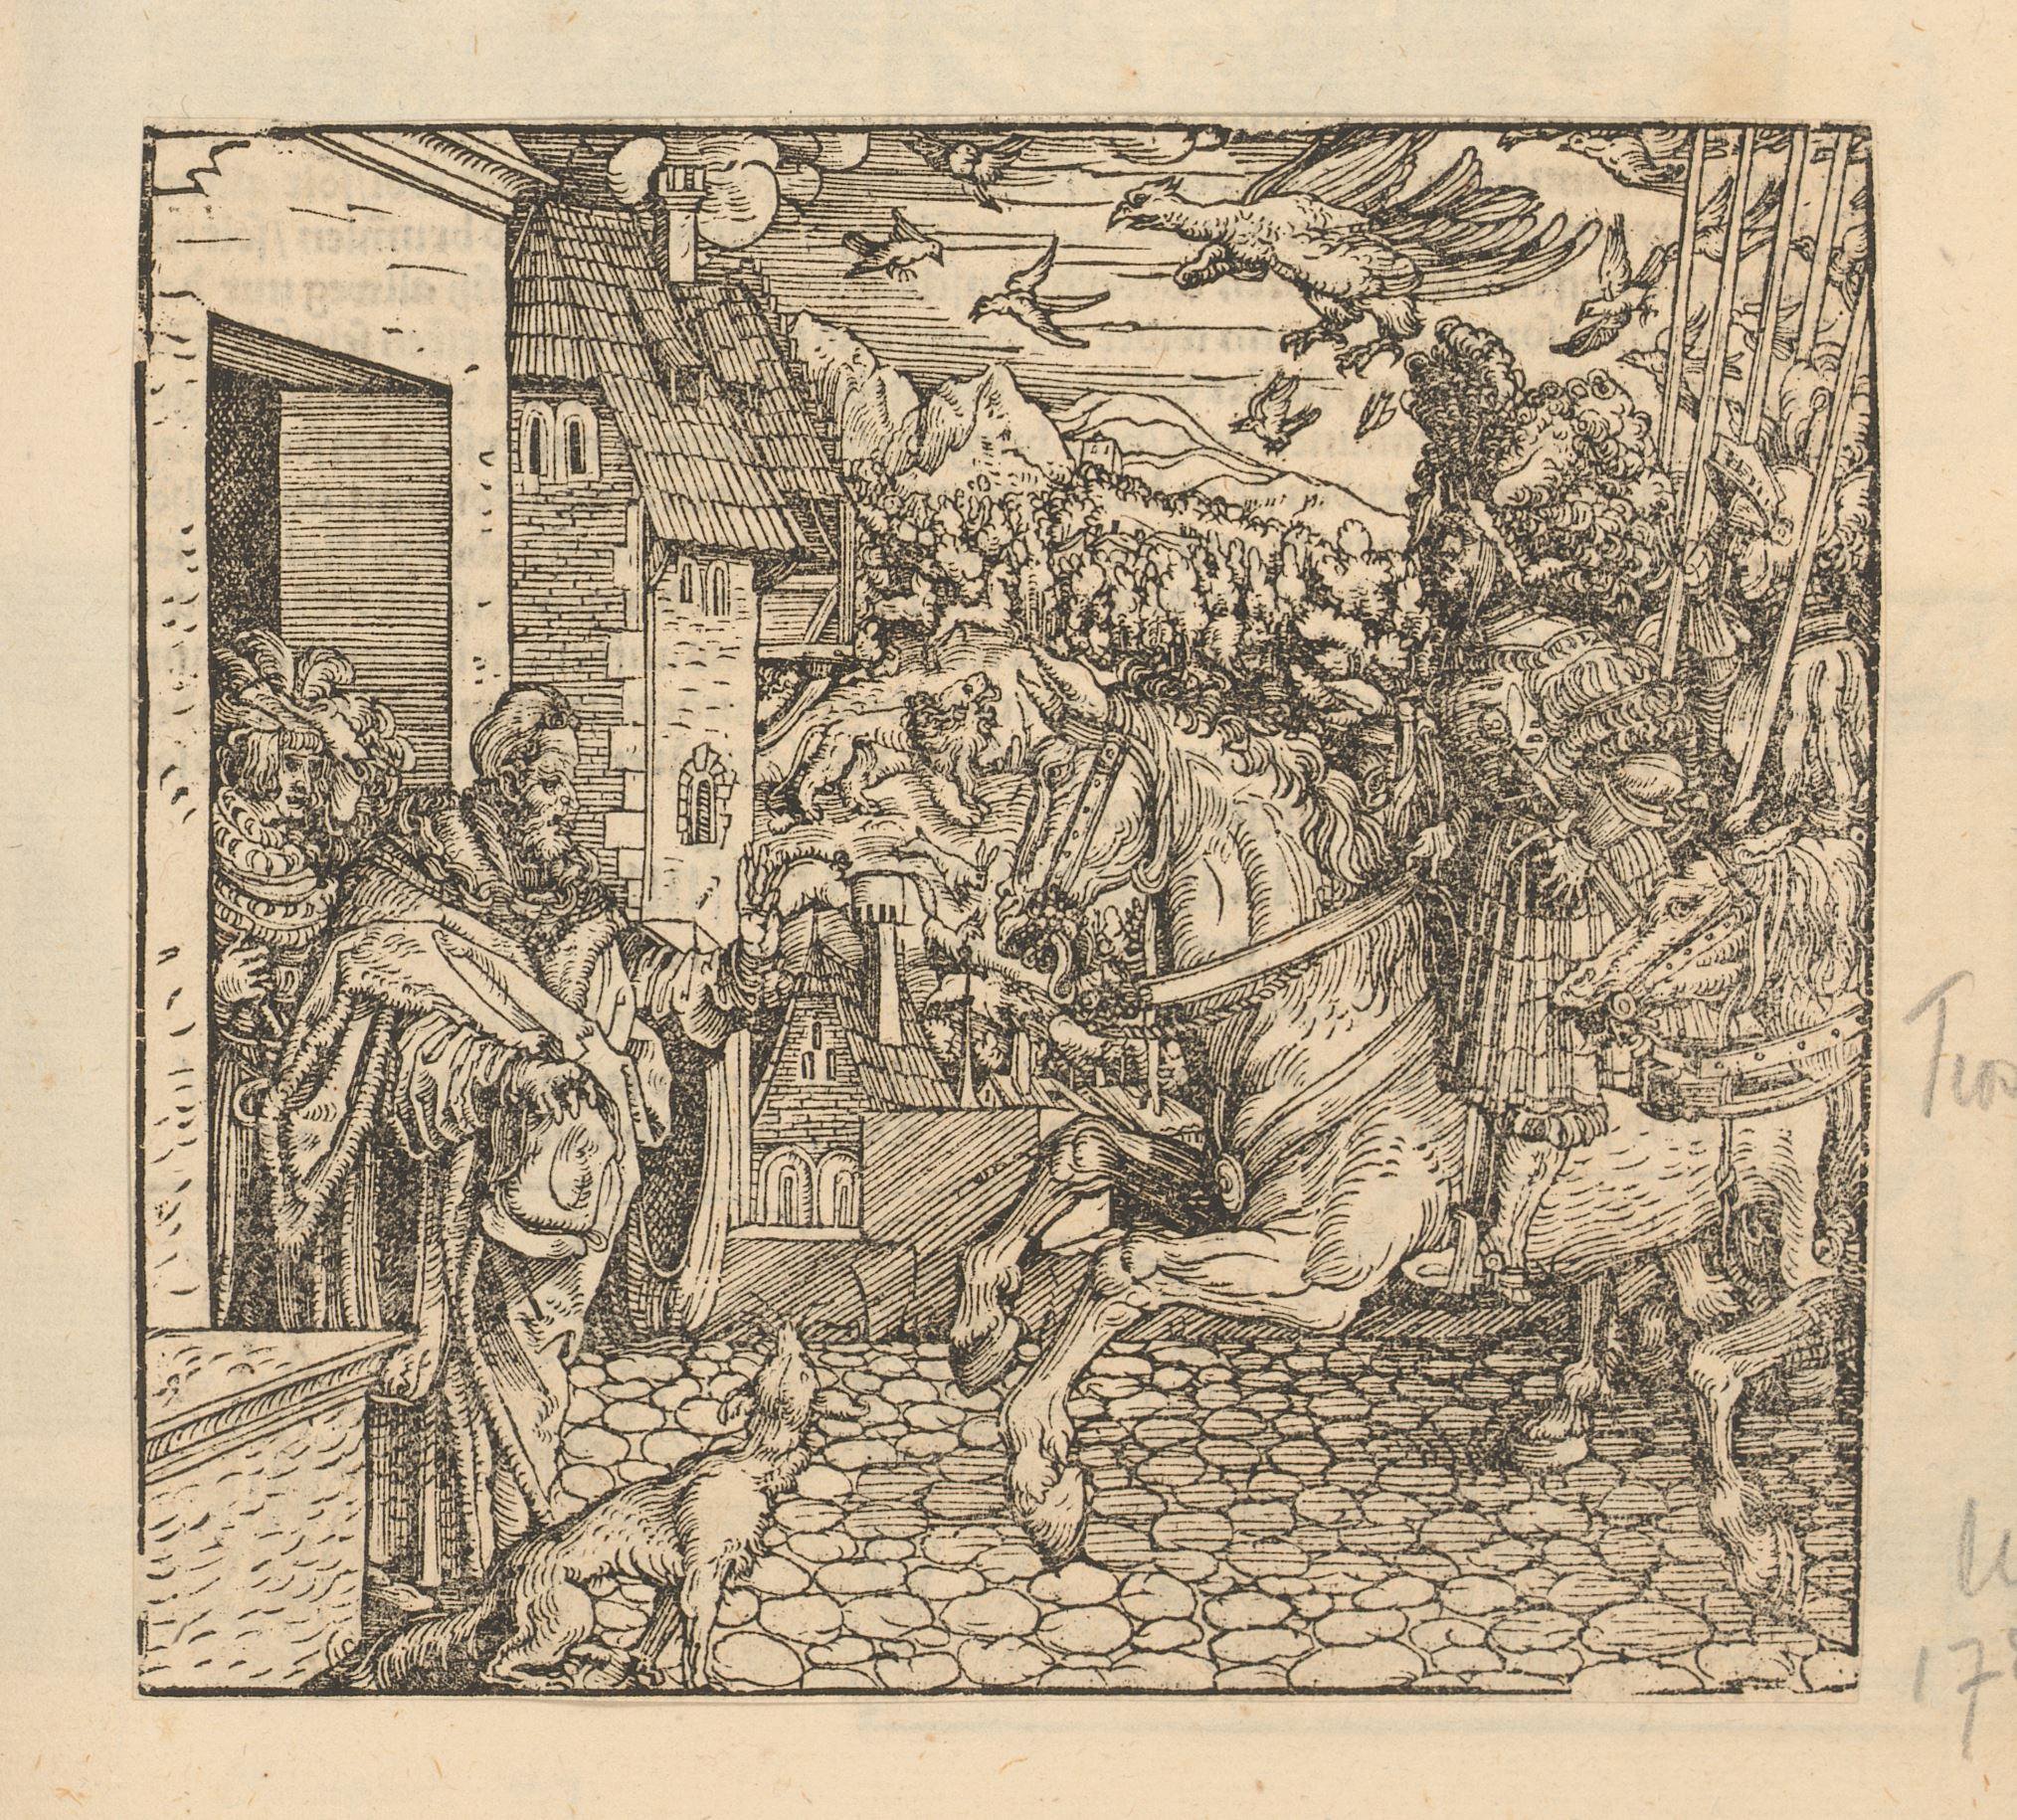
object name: book illustration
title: Ruiters worden ontvangen in een stad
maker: Anonymous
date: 1514-1532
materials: paper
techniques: letterpress printing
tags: riding a horse, ass, or mule; rider, horseman, reception ~ ambassador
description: Deze prent is gebruikt in: Petrarca, Francesco. Von der Artzney bayder Glück, des guten und widerwertigen: unnd weß sich ain yeder inn Gelück und Unglück halten sol (...). Augsburg: Heinrich Steiner, 1532. Deze uitgave is ook bekend onder de titel 'Trostspiegel in Glück und Unglück'.